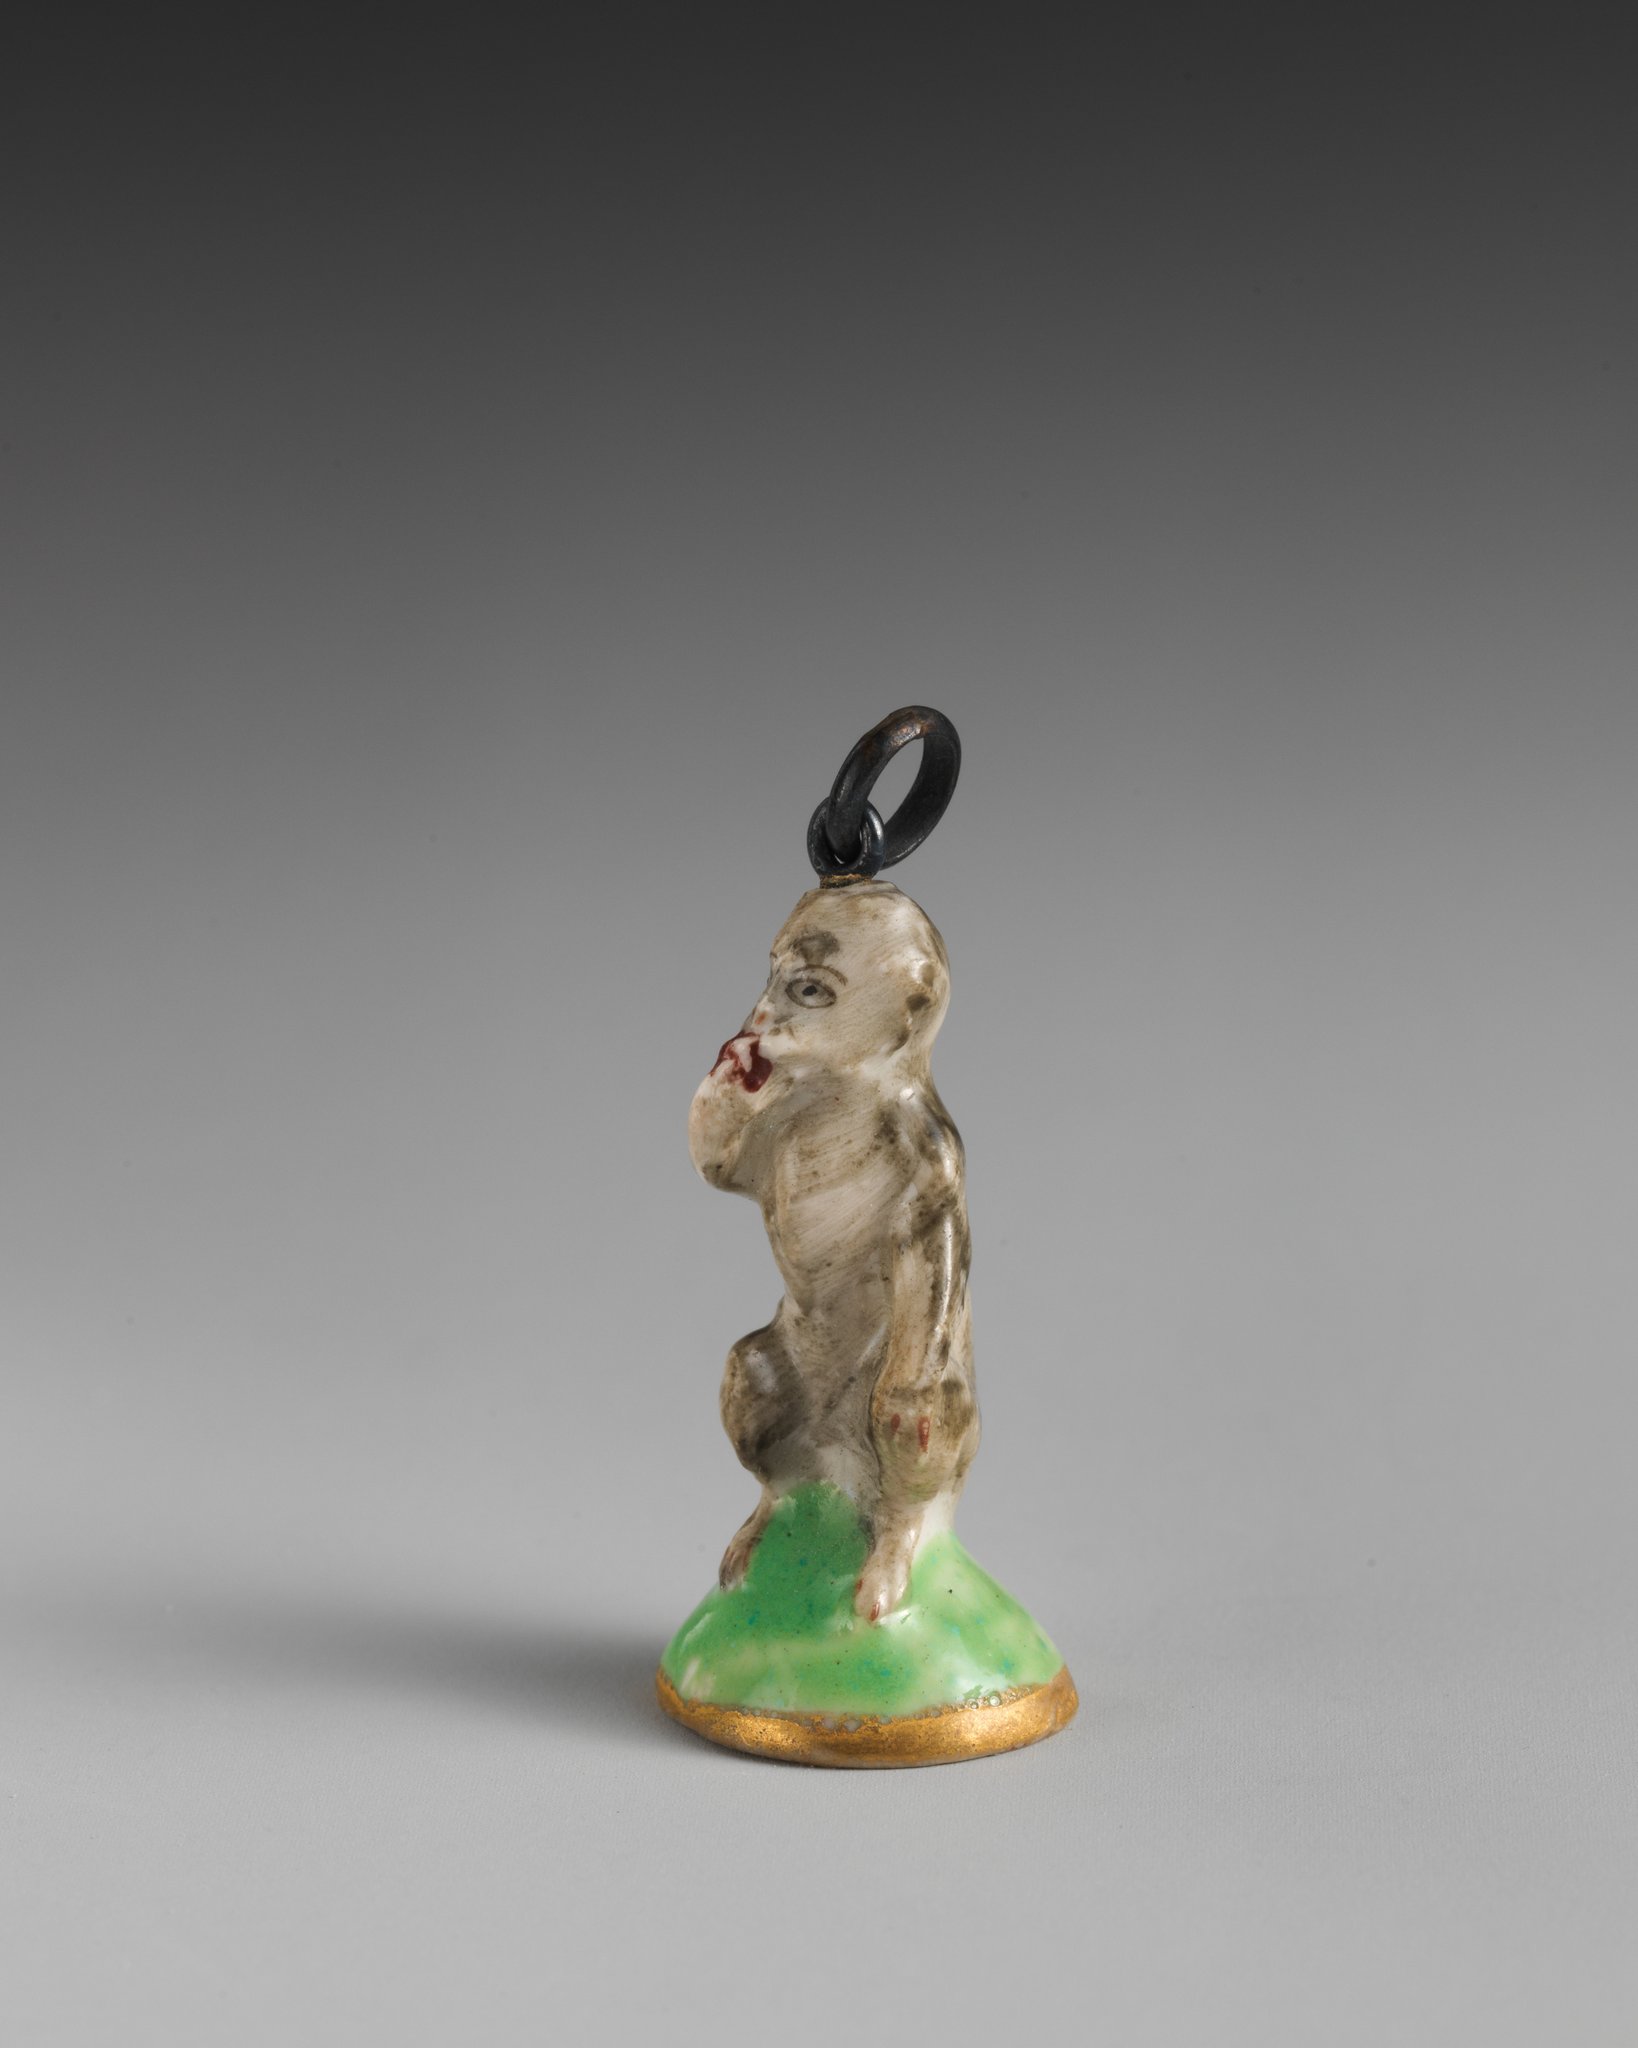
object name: seal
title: Monkey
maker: derby porcelain manufactory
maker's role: factory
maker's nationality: british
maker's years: 1751-1785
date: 1770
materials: soft paste porcelain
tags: monkeys